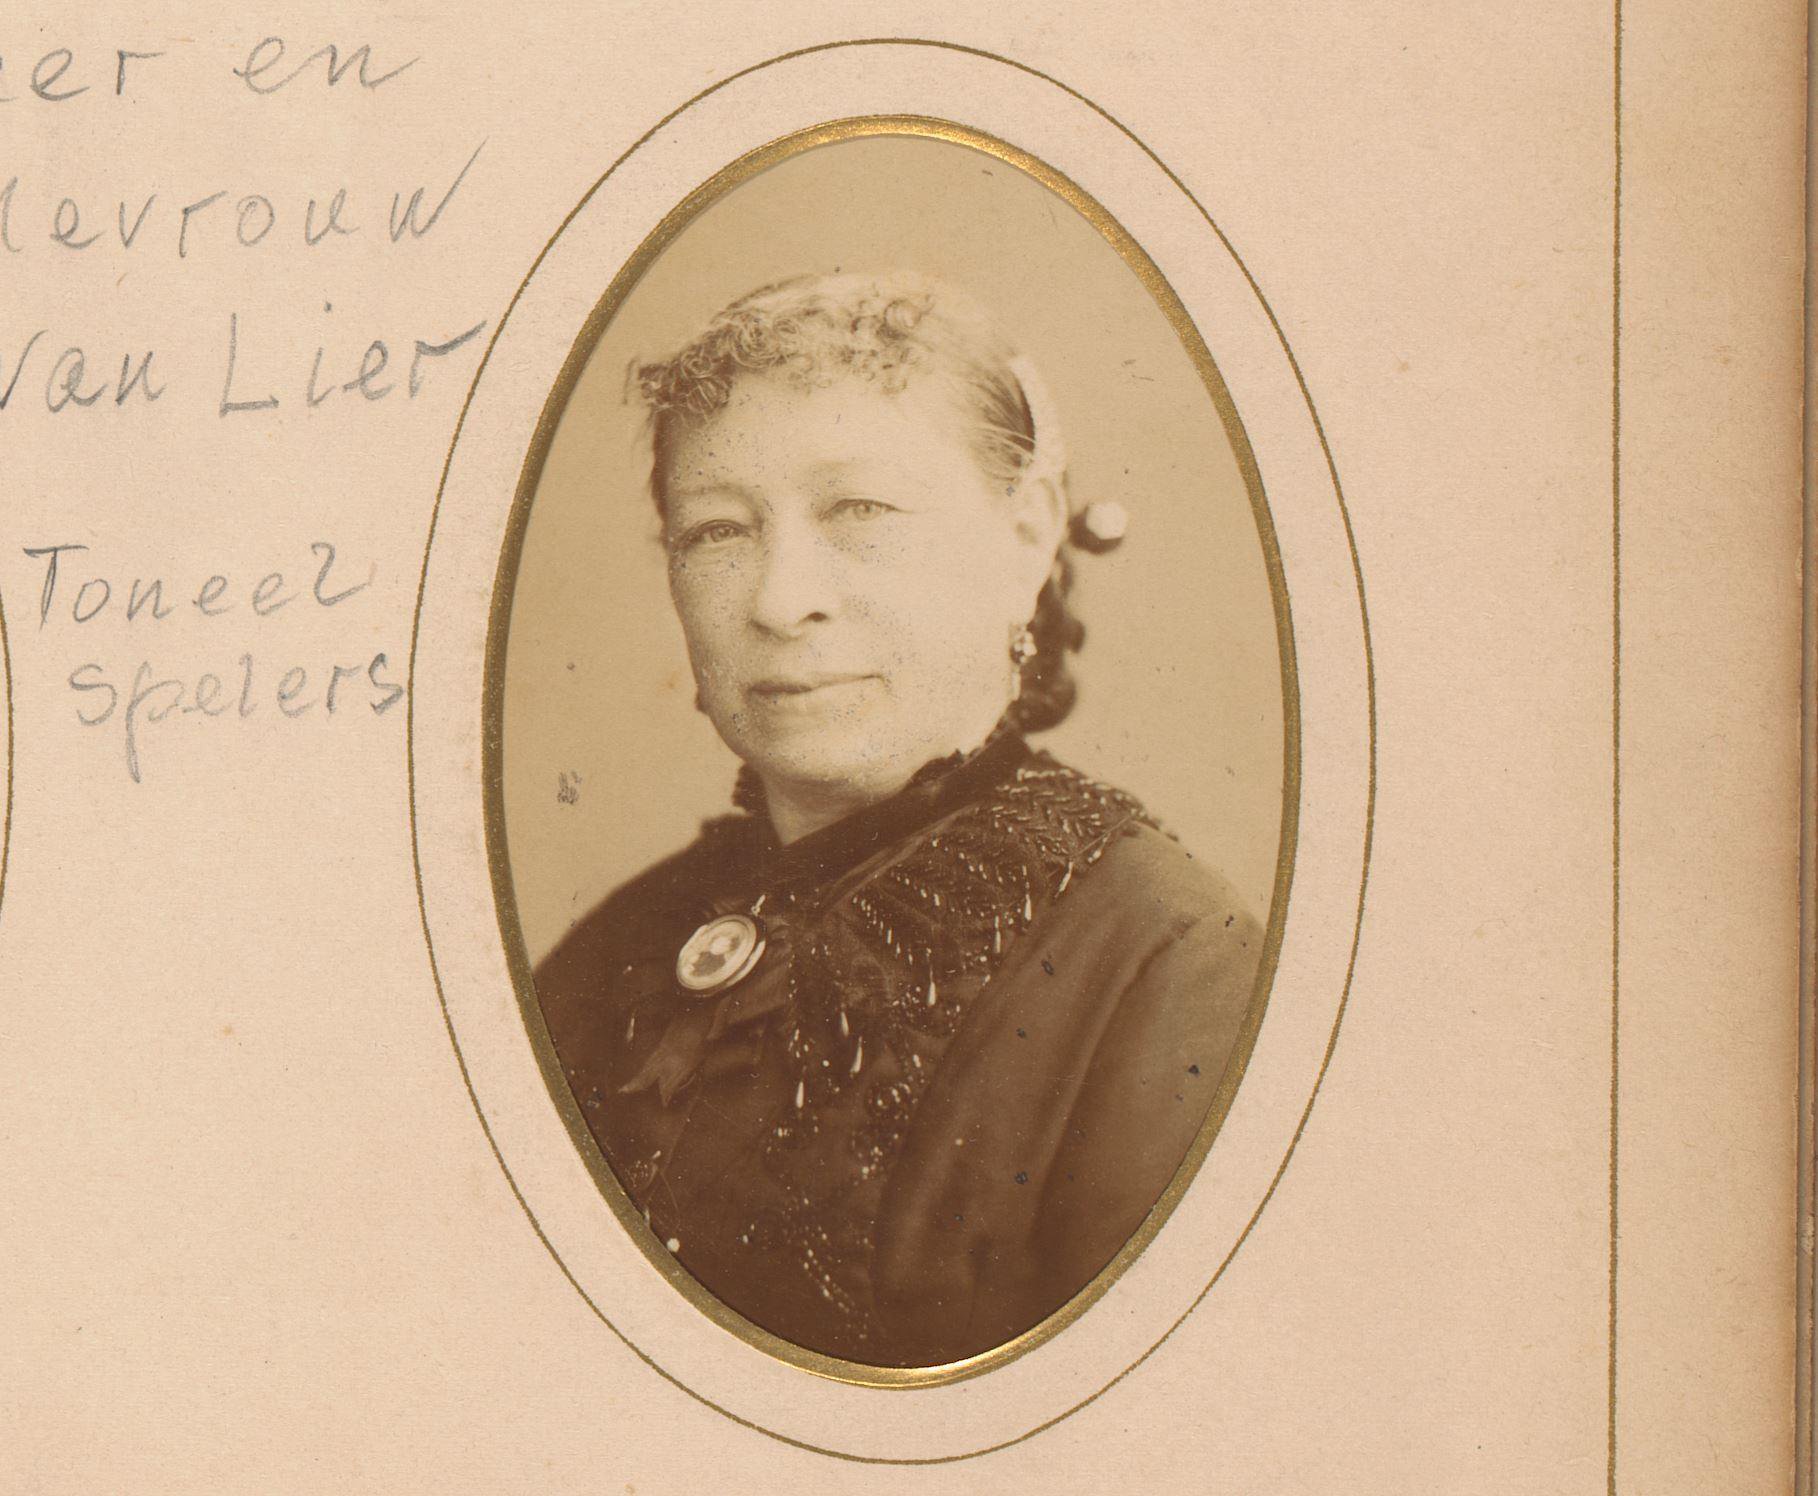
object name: photograph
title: Portret van de vrouw van Abraham van Lier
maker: carl borntraeger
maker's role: fotograaf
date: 1860-1890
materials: cardboard, photographic support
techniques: albumen print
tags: historical persons - bb - woman, portrait of actor, actress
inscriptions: inscription: ‘CARL/ BORNTRAEGER/ Hof-Photograph/ Taunus-/ Str. 2,/ an der/ Trinkhalle./ WIESBADEN./ Alle Platten werden für/ Nachbestellung reservirt.’, annotation: ‘Heer en/ Mevrouw/ van Lier/ Toneel/ spelers’